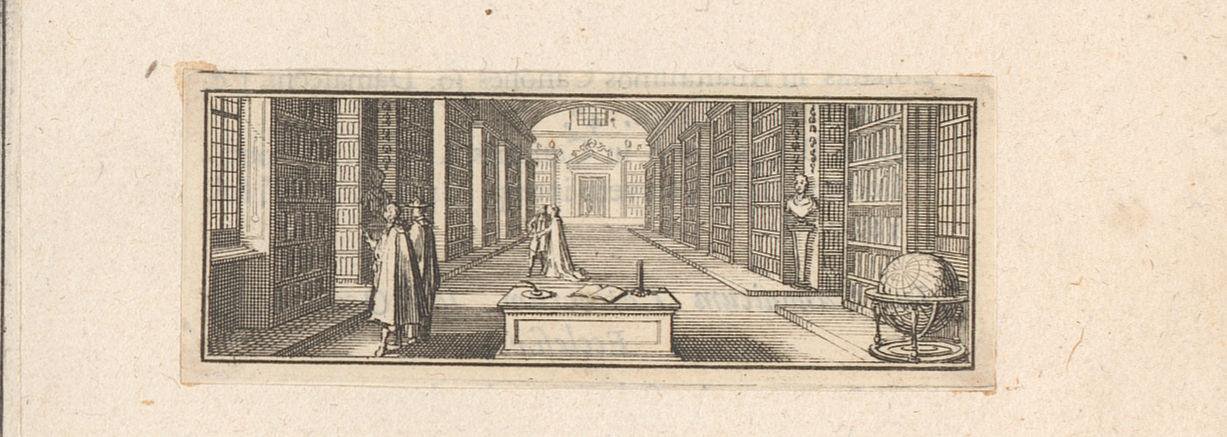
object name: book illustration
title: Vignet met figuren in een bibliotheek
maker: sébastien leclerc (i)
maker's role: print maker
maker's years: 1637-1714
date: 1679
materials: paper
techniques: etching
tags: study; 'studiolo'; library, vignette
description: Prent uit: Quesnel, Joseph. Catalogus bibliothecae thuanae (...). Parijs: s.n., 1679.